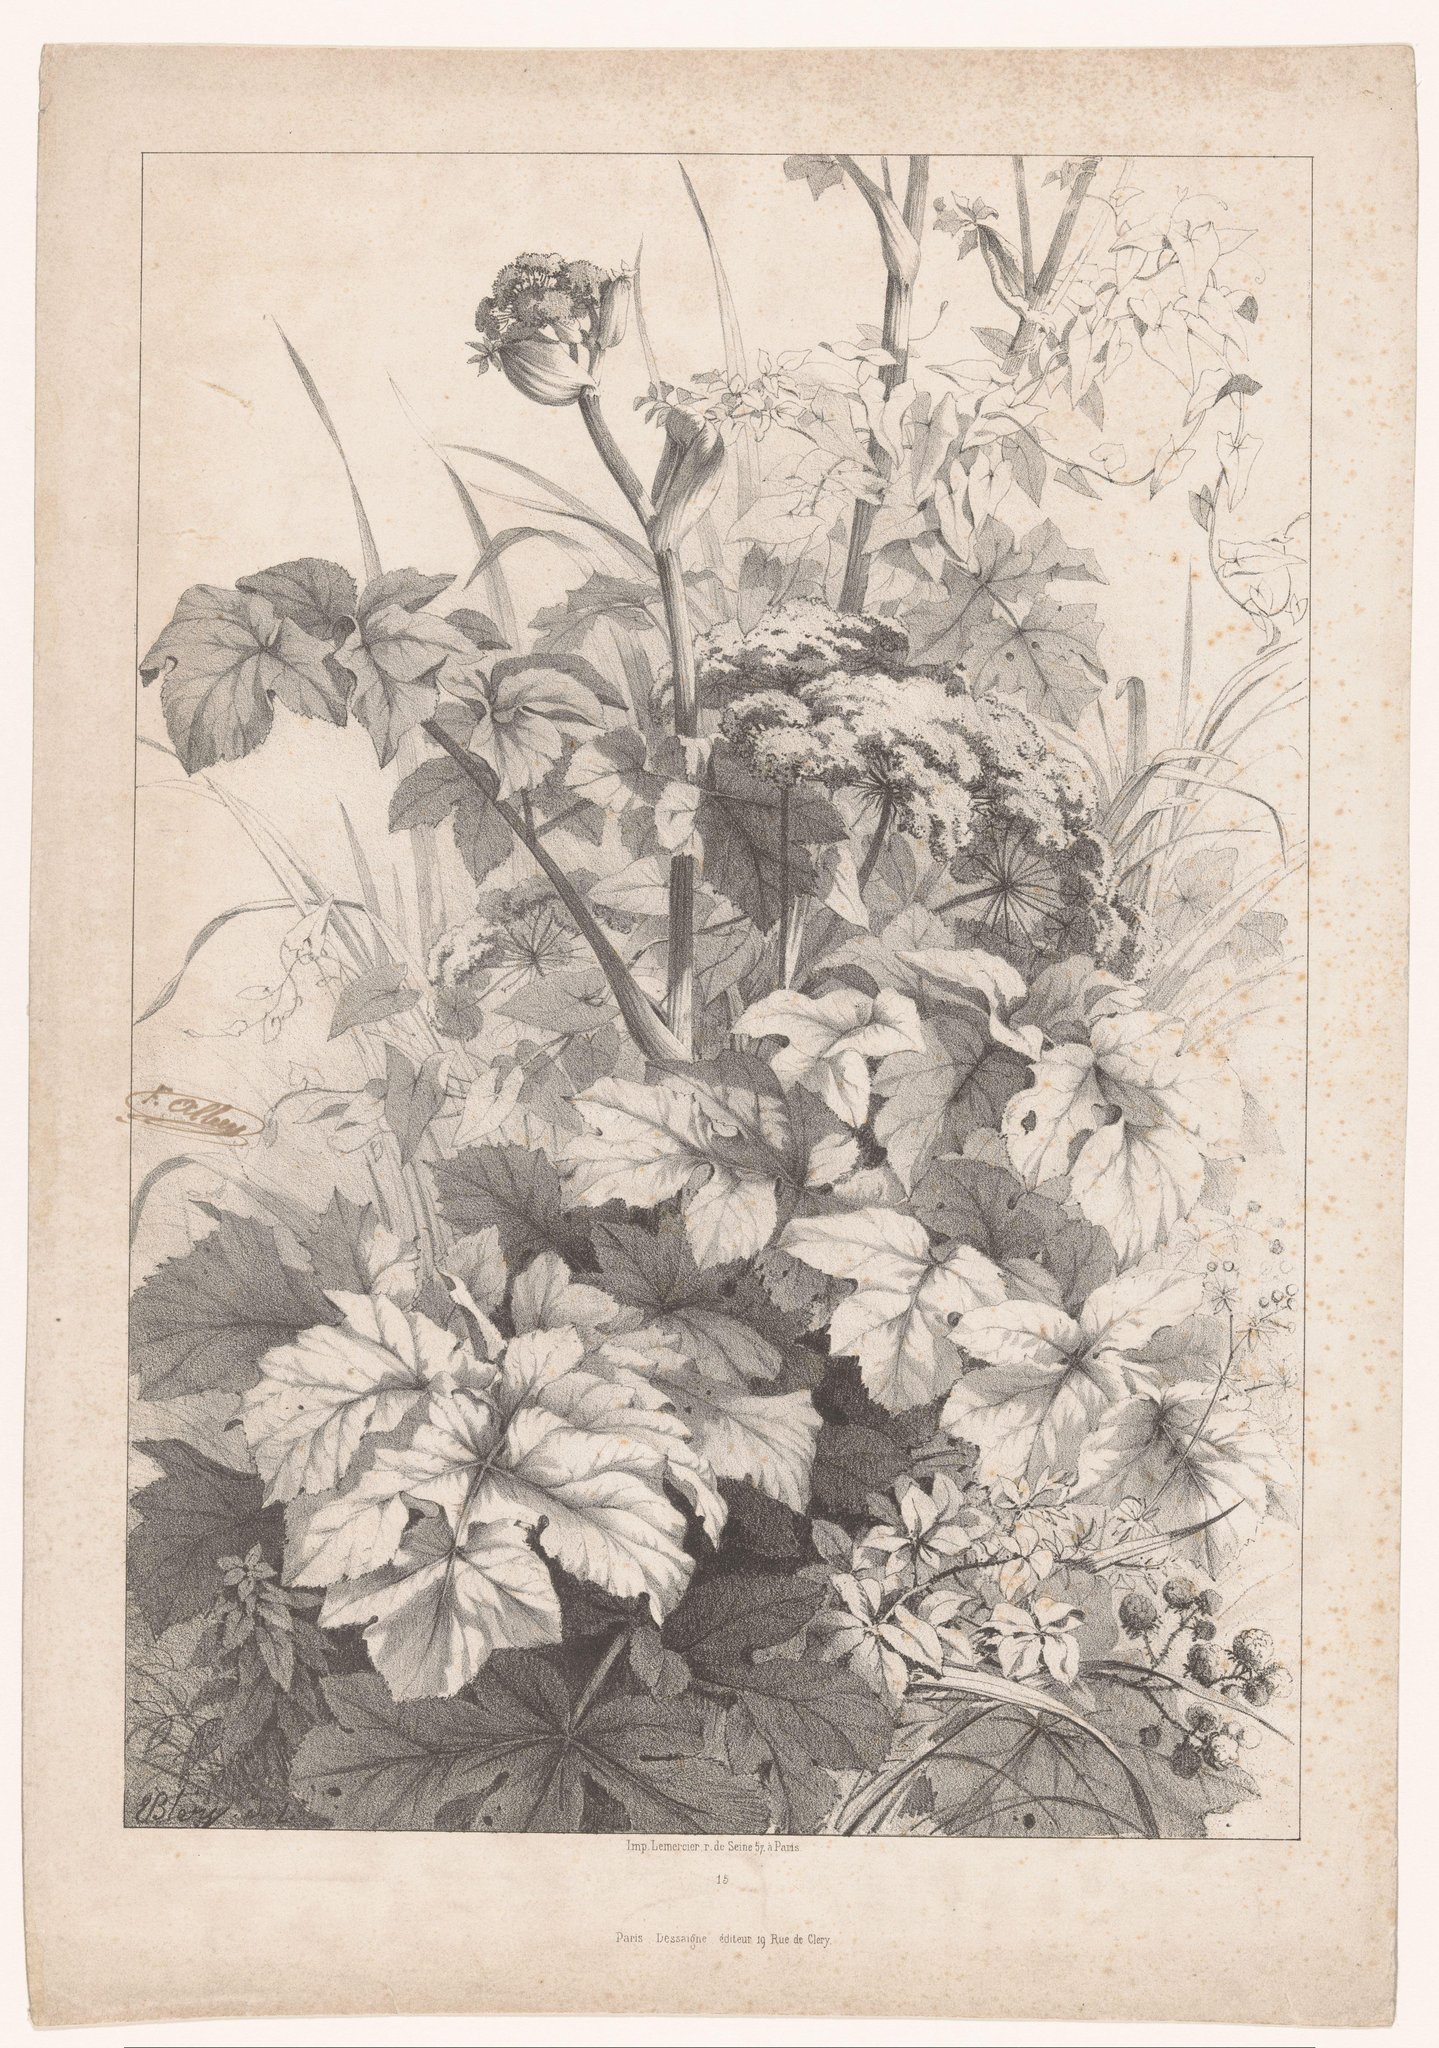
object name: print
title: Veldbloemen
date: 1856-1860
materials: paper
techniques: lithograph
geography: paris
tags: flowers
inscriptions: collector's mark: Lugt 2760, collector's mark: Lugt 2166, annotation: ‘F. Albers’